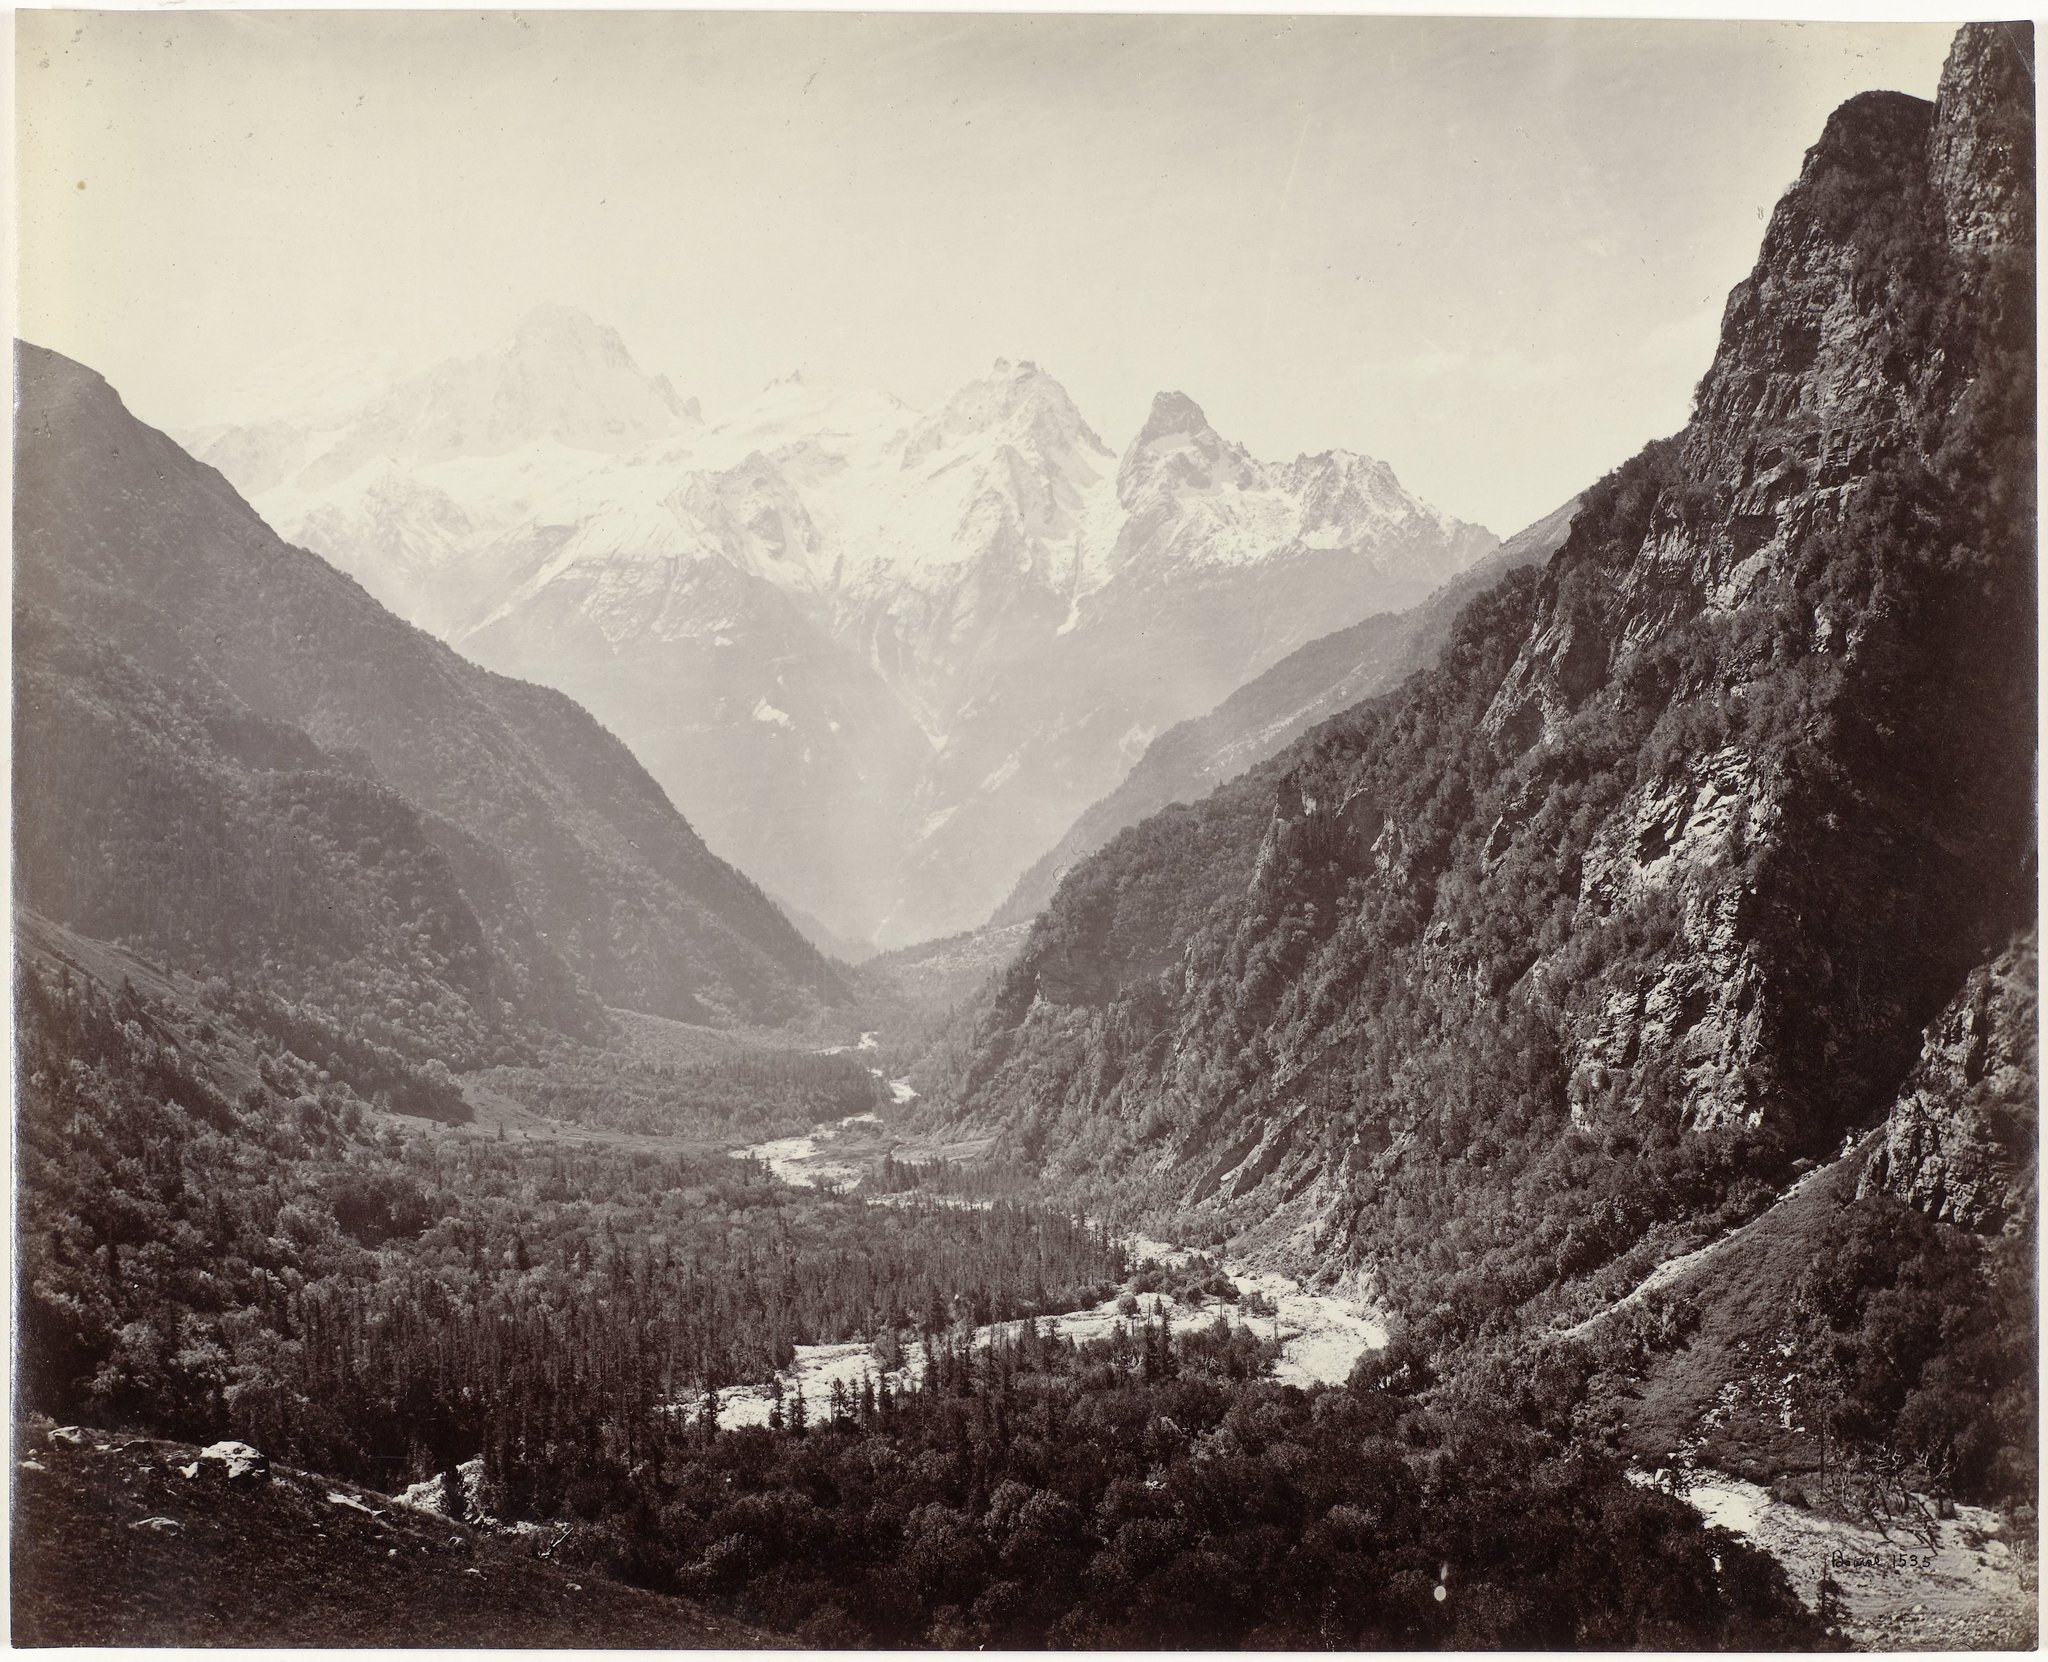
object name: photograph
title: Valley view and the Srikantha peak in the Himalayas, Uttarakhand, India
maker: samuel bourne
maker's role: fotograaf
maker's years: 1834-1912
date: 1863-1865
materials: paper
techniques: albumen print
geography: uttarakhand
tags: dale, valley, mountain-range, snow peaks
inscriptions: number: ‘1535’, name: ‘Bourne’, inscription: ‘1535/ 1535/ Wooded Valley Fuladaru/ with the Srikanta Peaks/ in the Distance’, inscription: ‘Samuel Bourne f750,-’